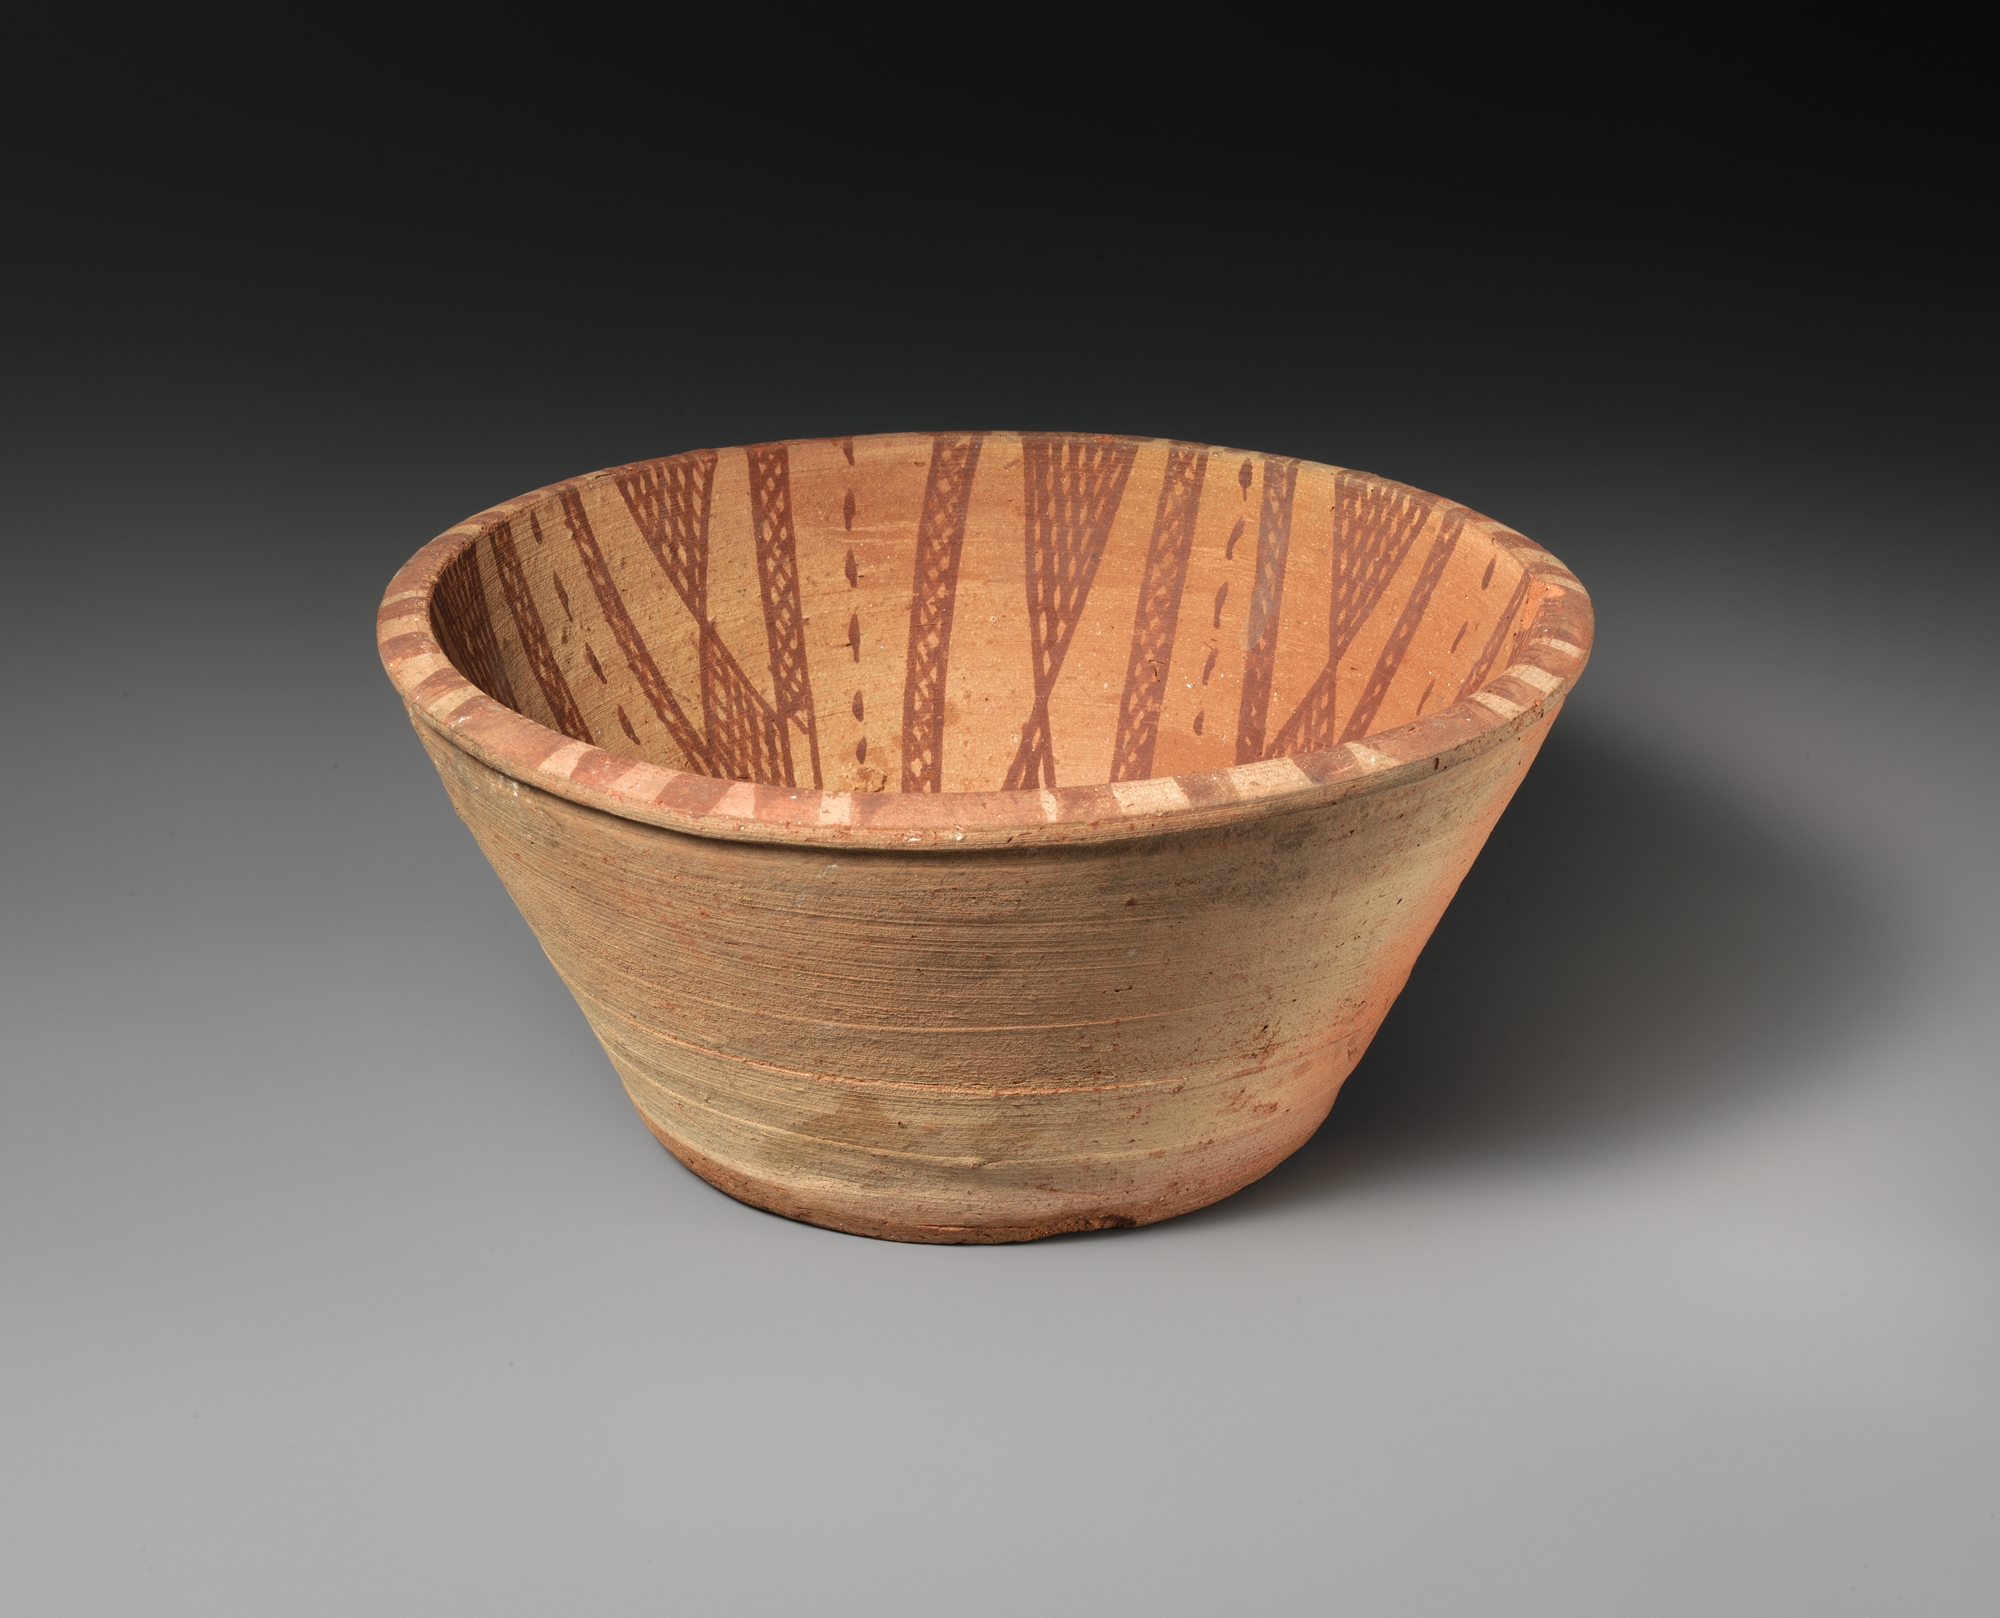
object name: bowl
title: Bowl with Interior Geometric Decoration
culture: coptic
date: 301-700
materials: earthenware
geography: egypt